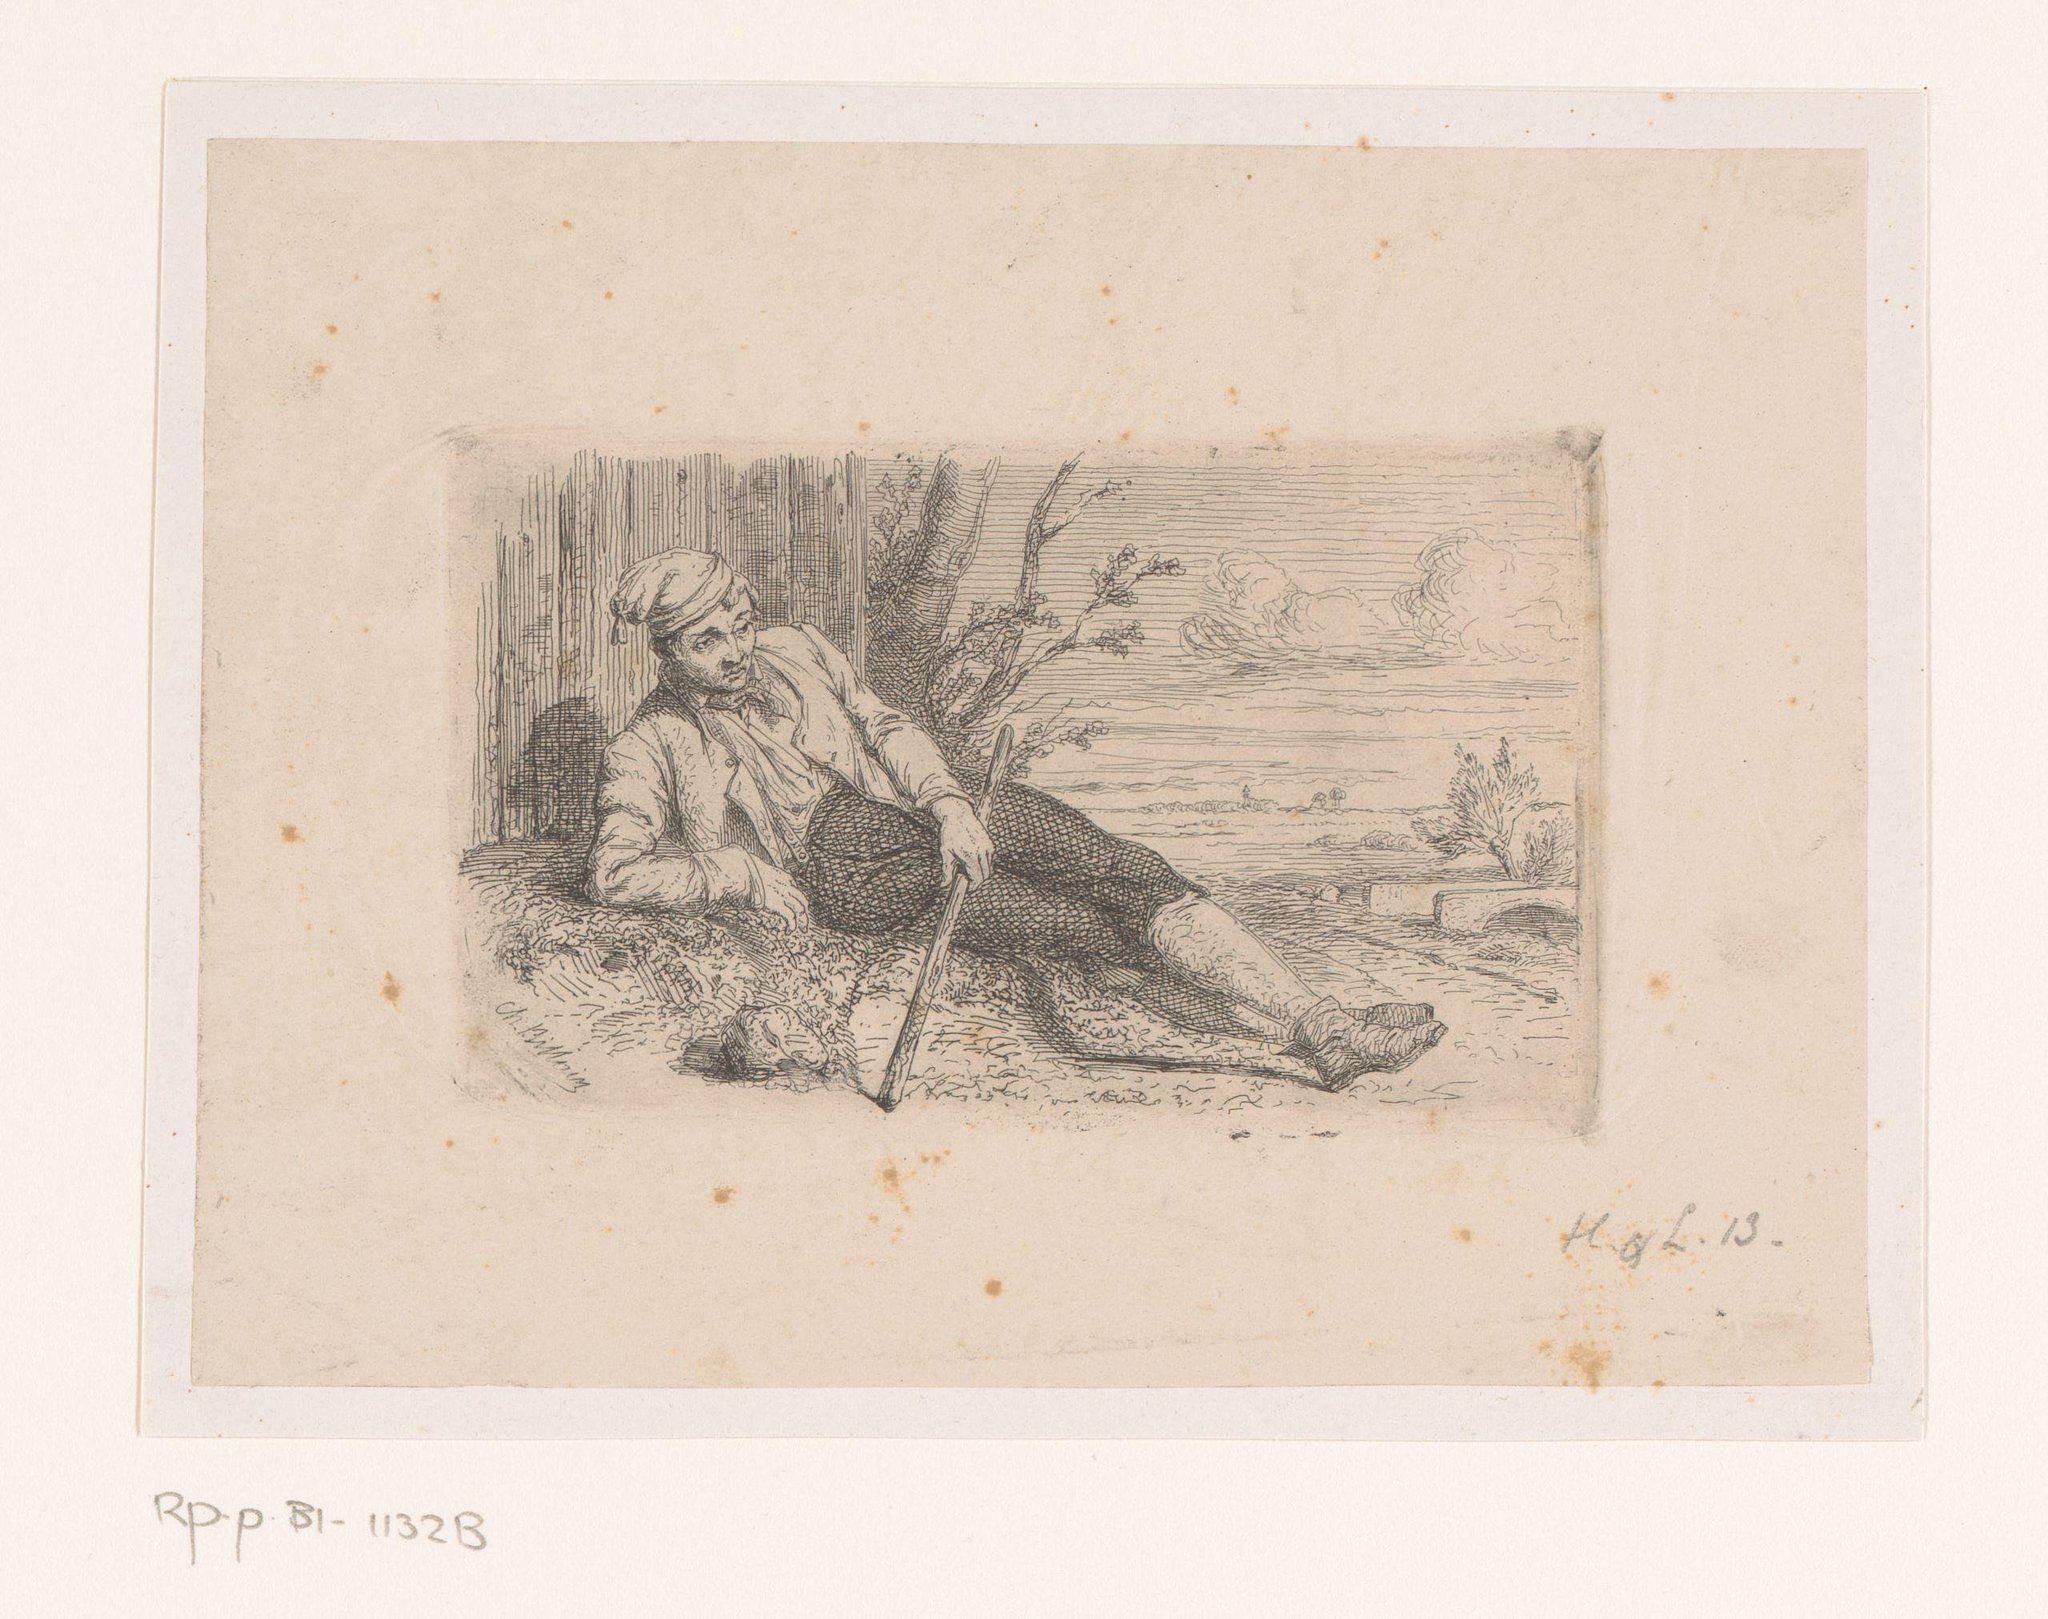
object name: print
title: Rustende man in de open lucht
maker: charles billoin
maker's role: painter, print maker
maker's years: 1813-1869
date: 1823-1869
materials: paper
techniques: etching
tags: (traveller) resting in the open air, resting - bb - out of doors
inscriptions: collector's mark: Lugt 2228